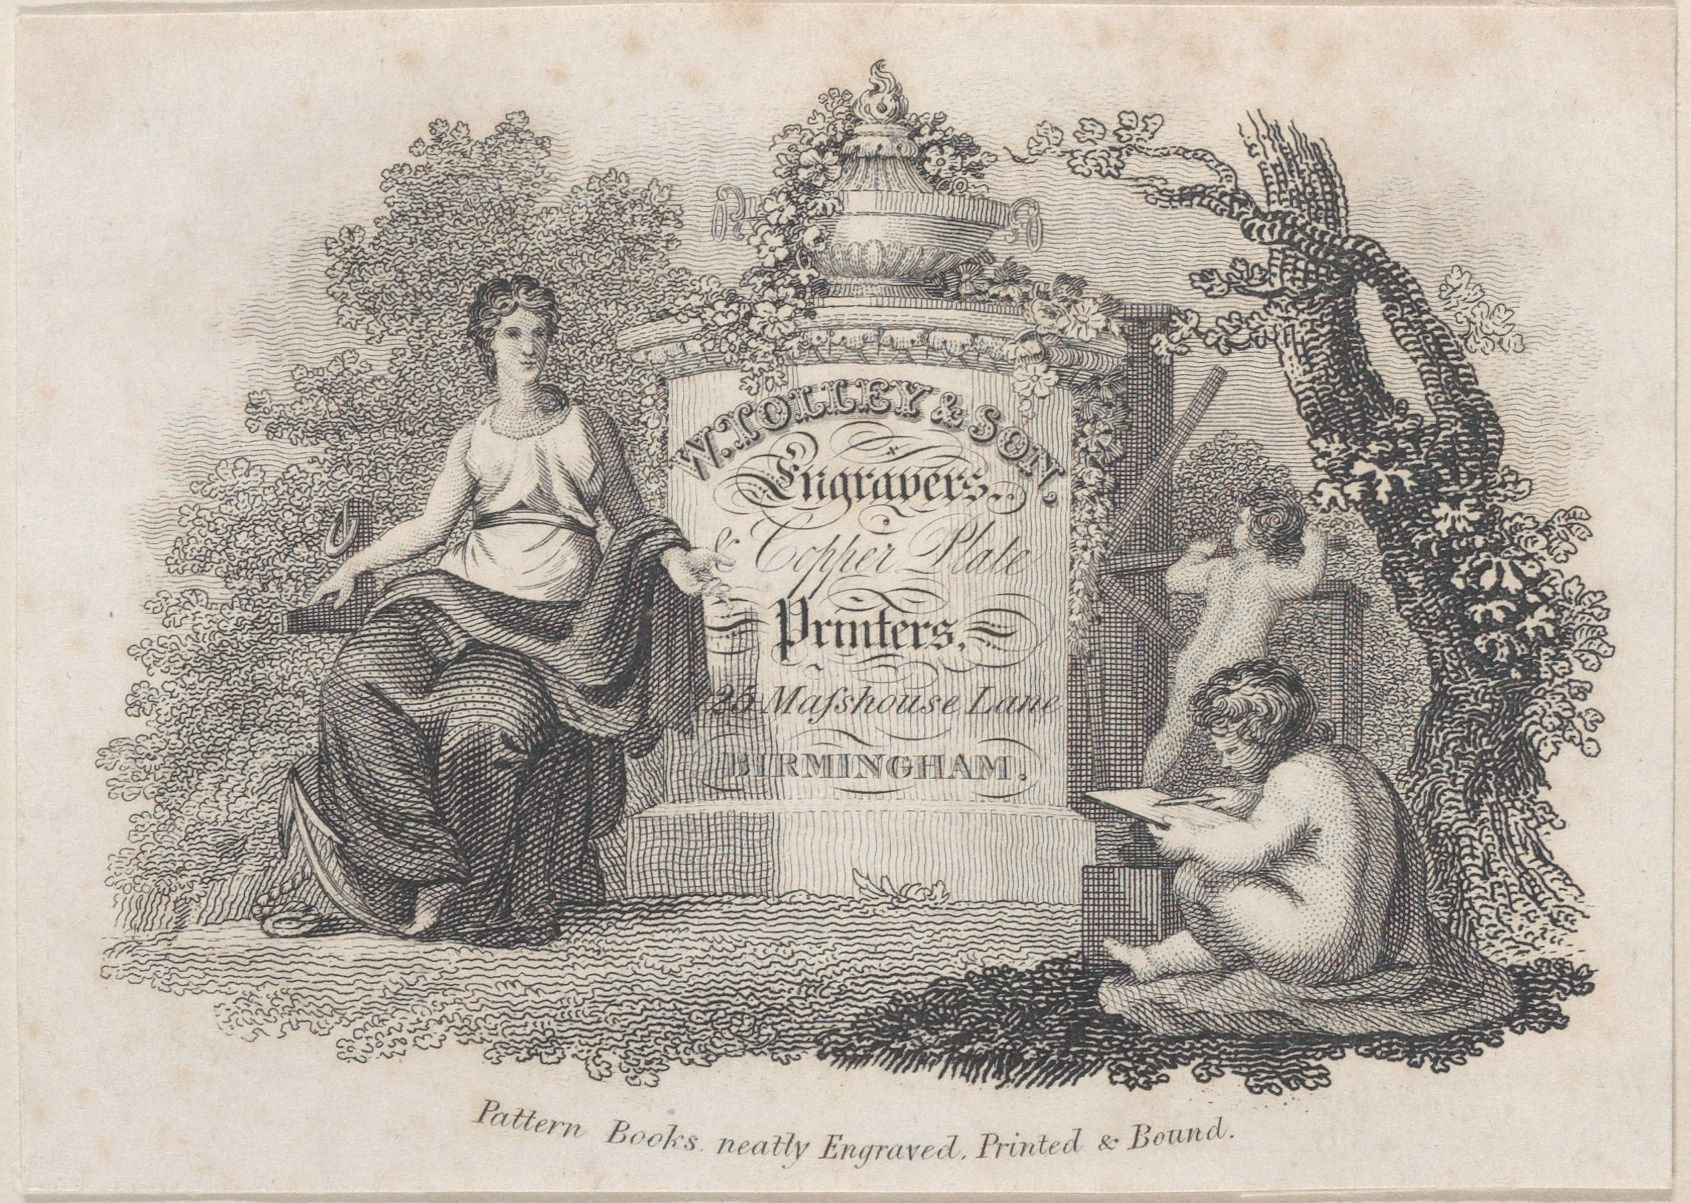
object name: print, trade card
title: Trade Card for W. Holley & Son, Engravers and Printers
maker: anonymous, british, 19th century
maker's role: artist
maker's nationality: british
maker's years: 1800-1900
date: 1801-1900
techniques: engraving